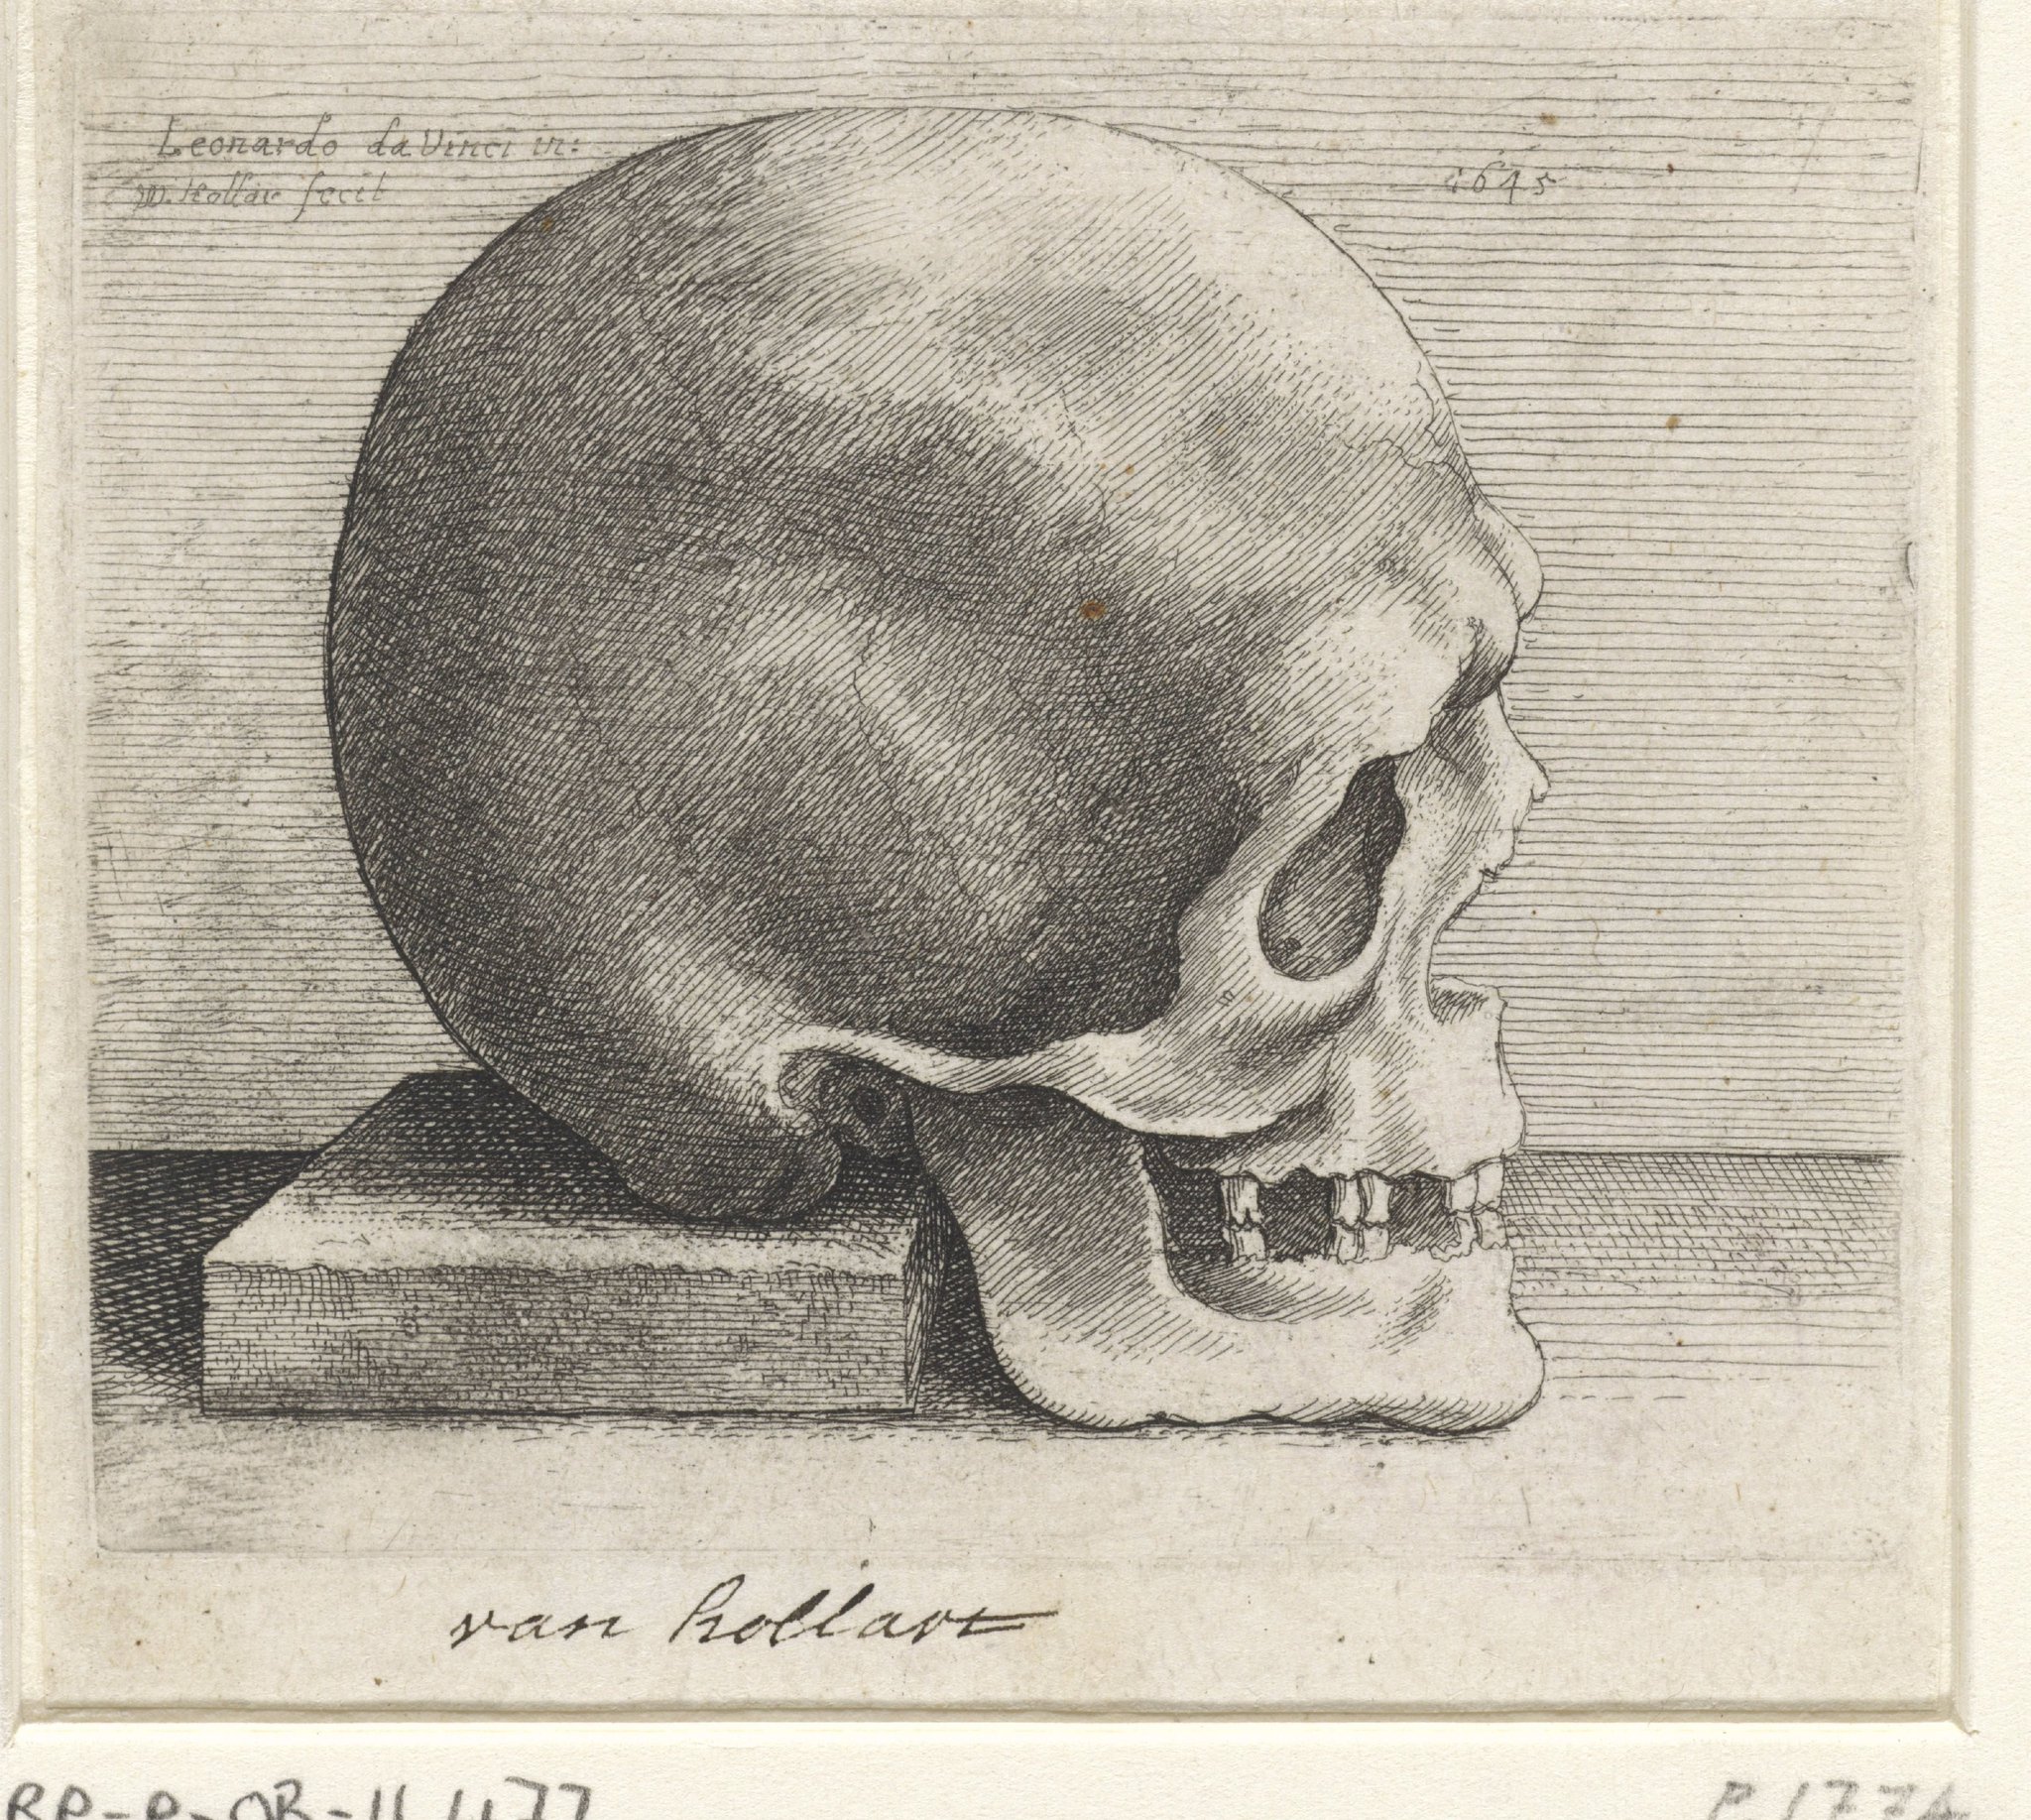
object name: print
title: Anatomische studie van een schedel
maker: wenceslaus hollar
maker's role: draughtsman, print maker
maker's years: 1607-1677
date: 1645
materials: paper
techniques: etching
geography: antwerp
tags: (human) skull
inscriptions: collector's mark: Lugt 240, inscription: ‘van Hollar’